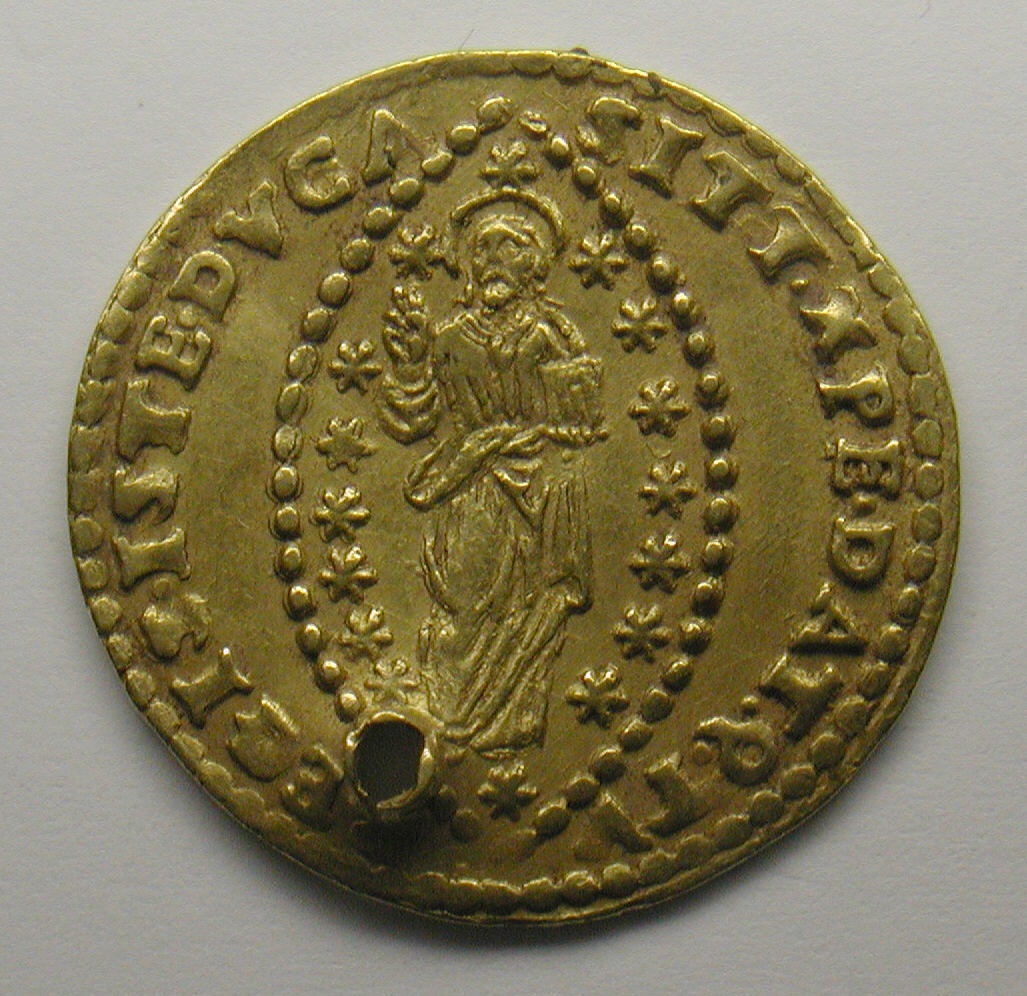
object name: coin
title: Zecchino, Domenico Contarini (1659–75)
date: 1659-1675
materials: gold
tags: men,flowers,coins